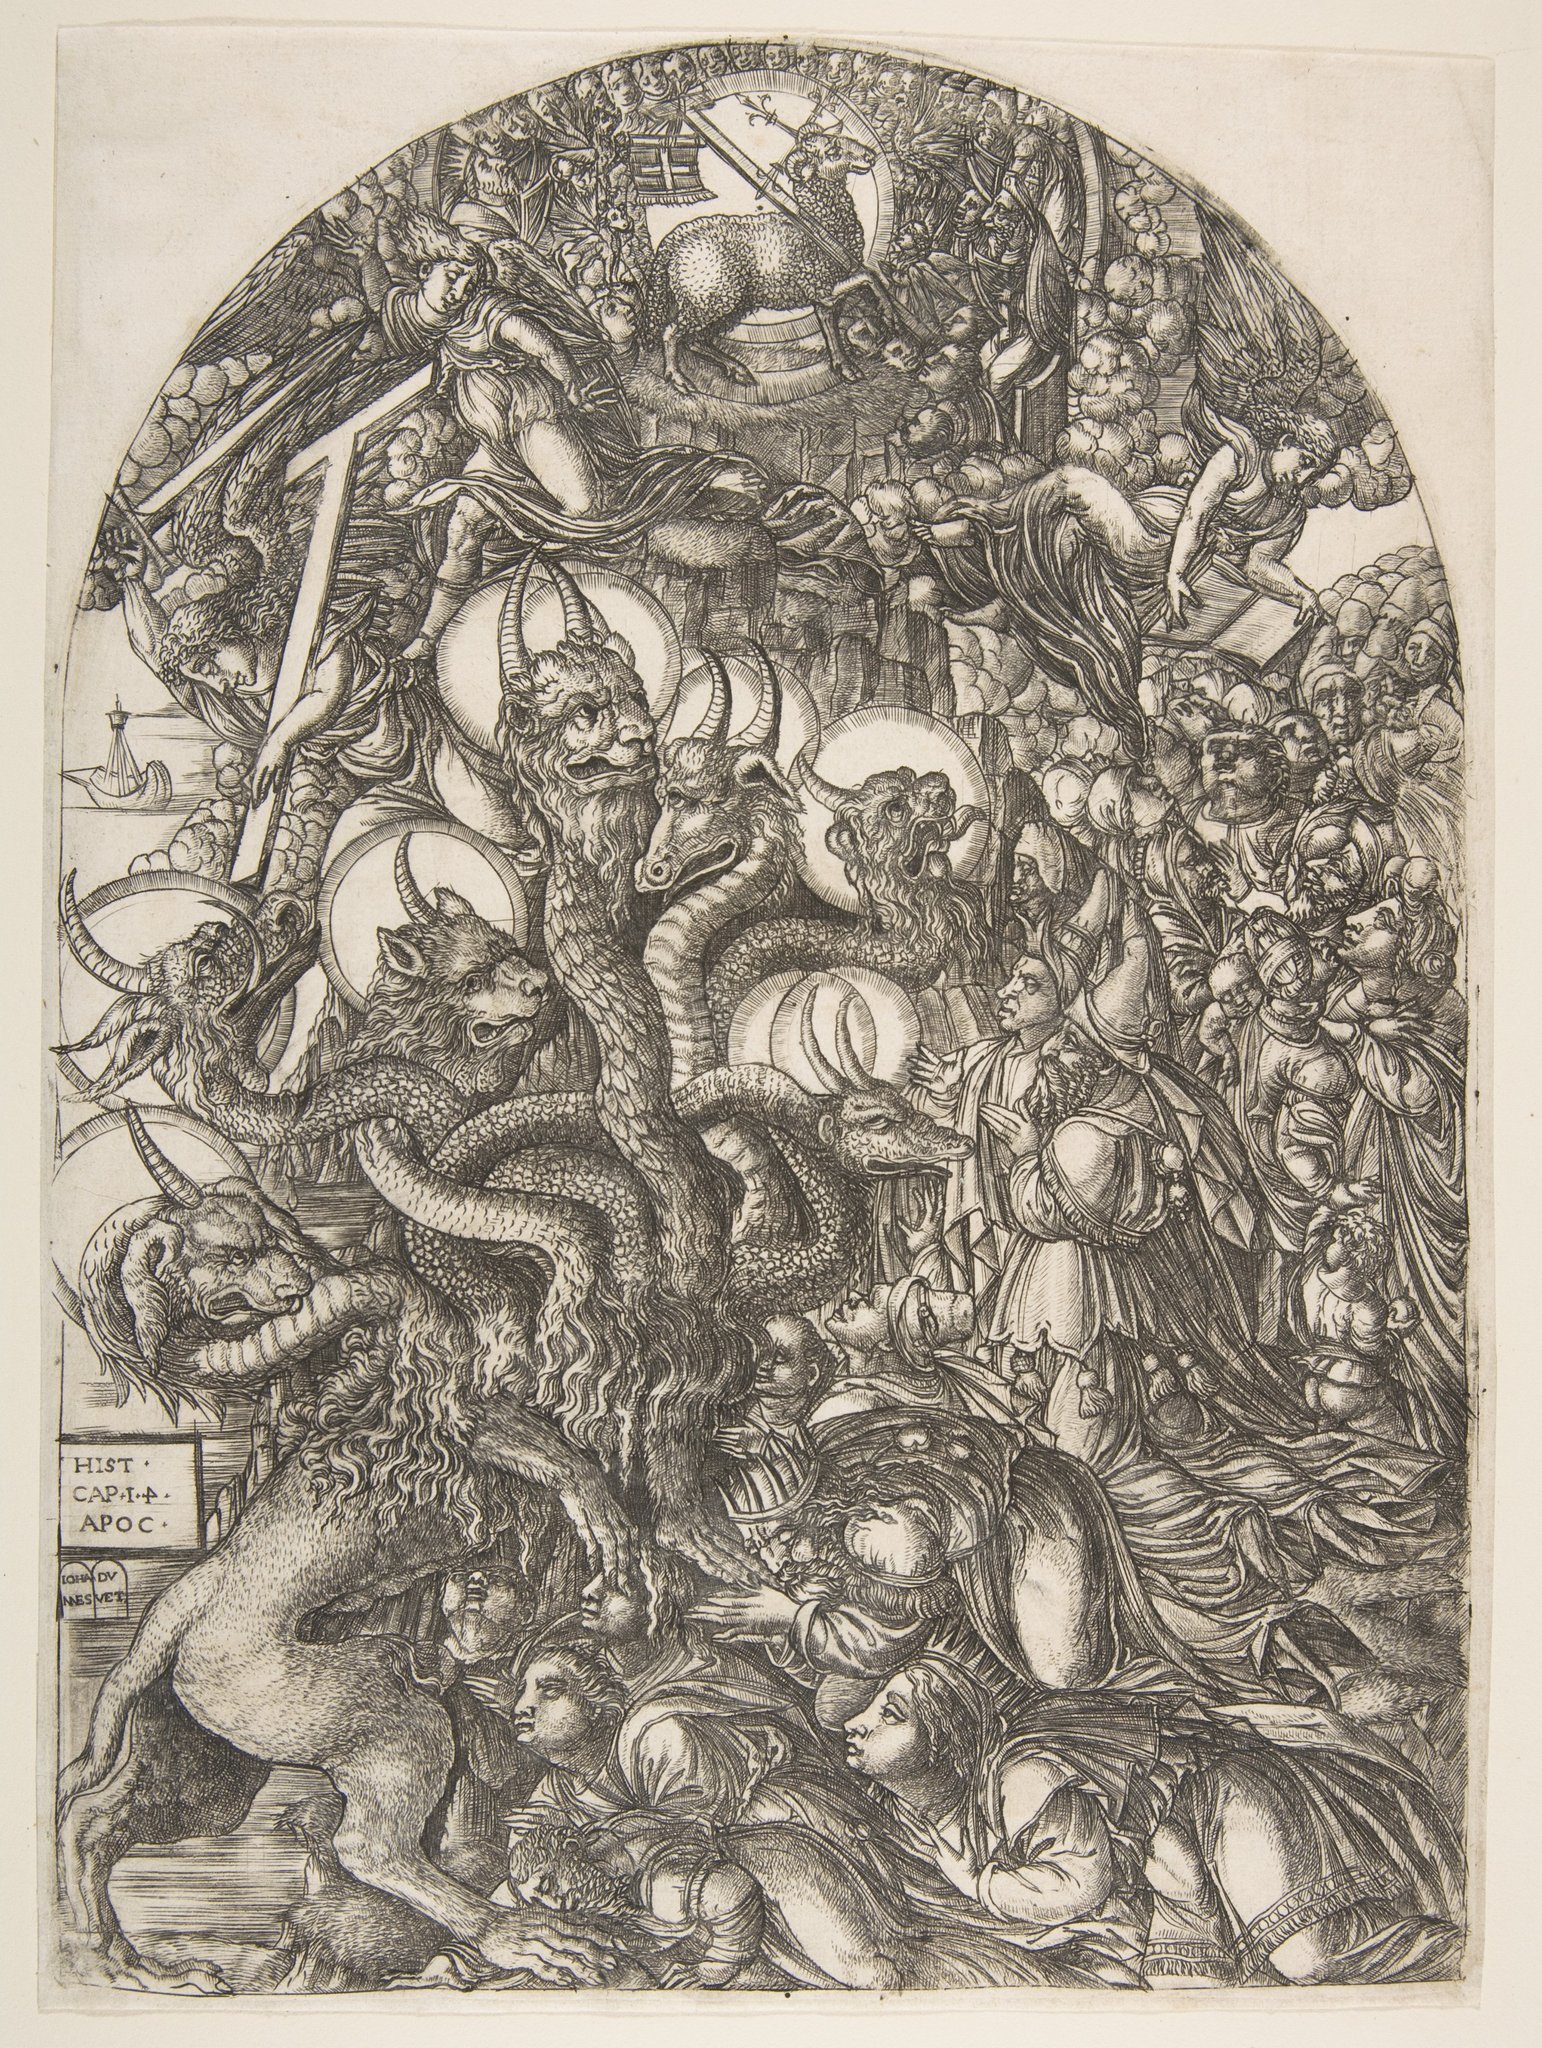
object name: print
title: The Beast with Seven Heads and Ten Horns, from the Apocalypse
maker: jean duvet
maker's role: artist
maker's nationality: french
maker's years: 1485-1561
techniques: engraving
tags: human figures,animals